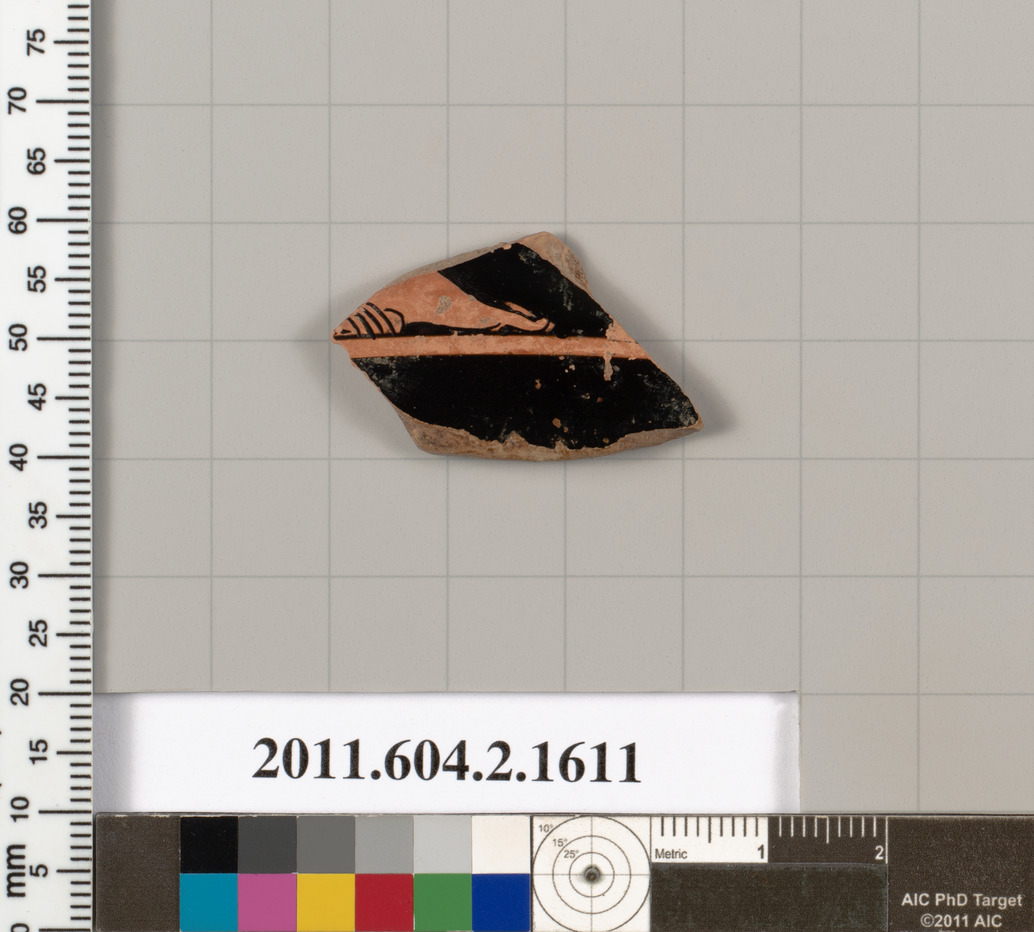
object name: skyphos fragment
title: Terracotta fragment of a skyphos (deep drinking cup)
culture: greek, attic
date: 475-451 BCE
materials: terracotta